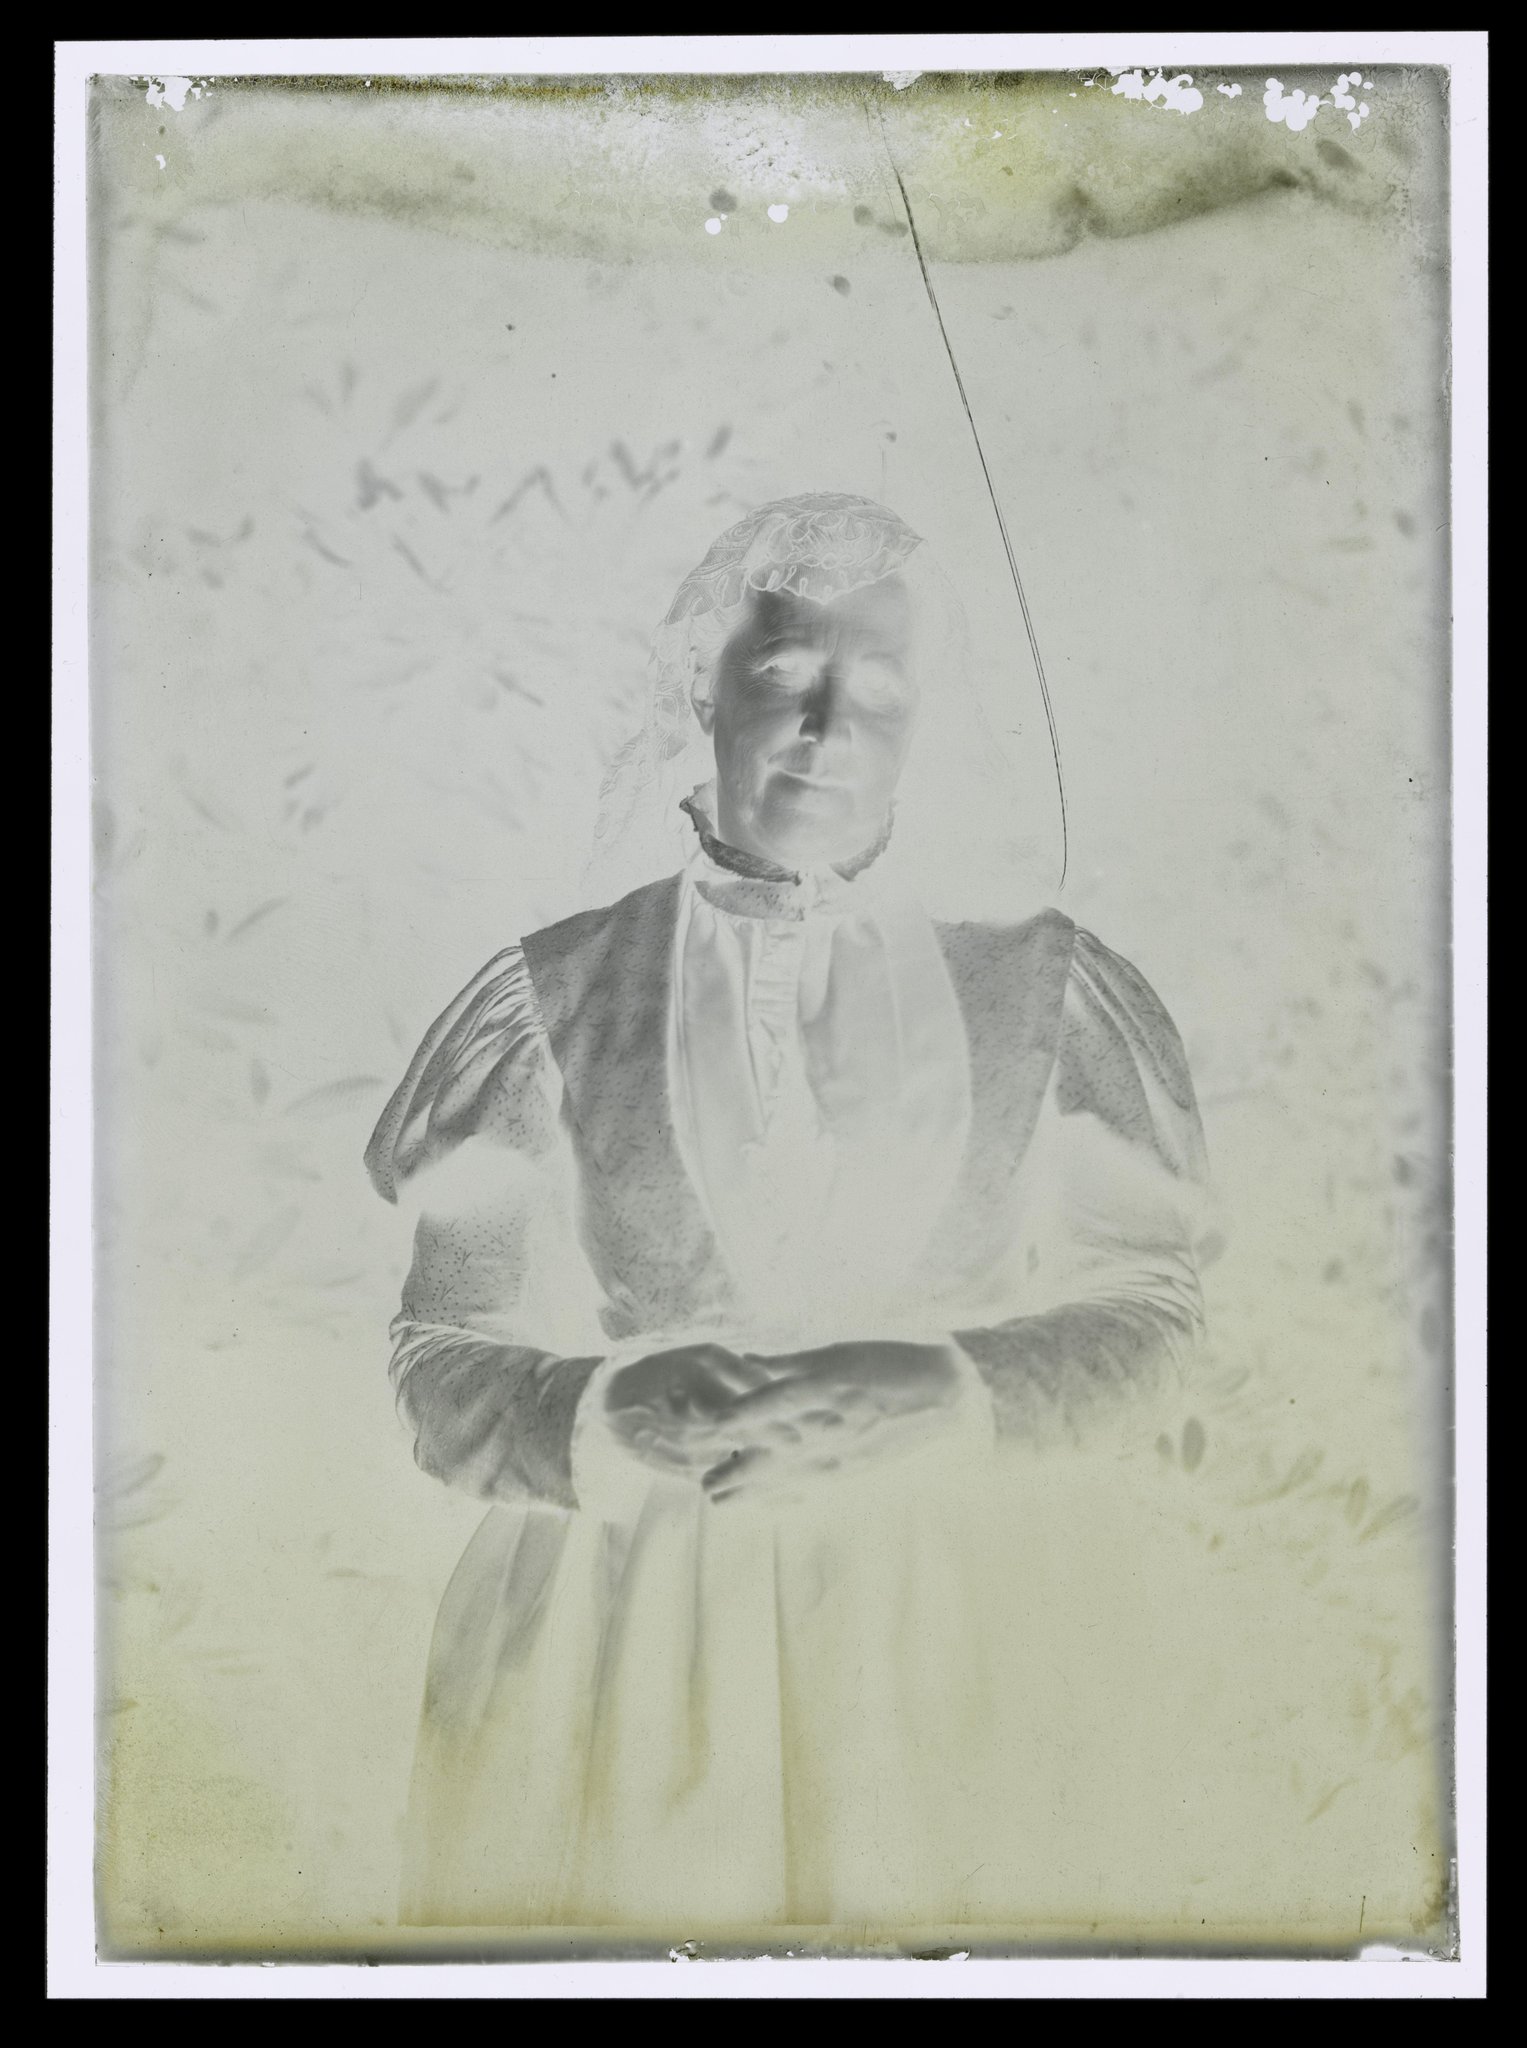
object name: glasnegatief, glasplaatnegatief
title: Portret van een onbekende vrouw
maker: laurens lodewijk kleijn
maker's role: draughtsman, painter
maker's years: 1826-1909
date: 1865-1900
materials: glass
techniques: collodion process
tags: anonymous historical person portrayed - bb - woman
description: Onderdeel van een groep glasnegatieven uit de nalatenschap van de schilder Laurens Lodewijk Kleijn, met stillevens, portretten, zelfportretten en kunstreproducties.